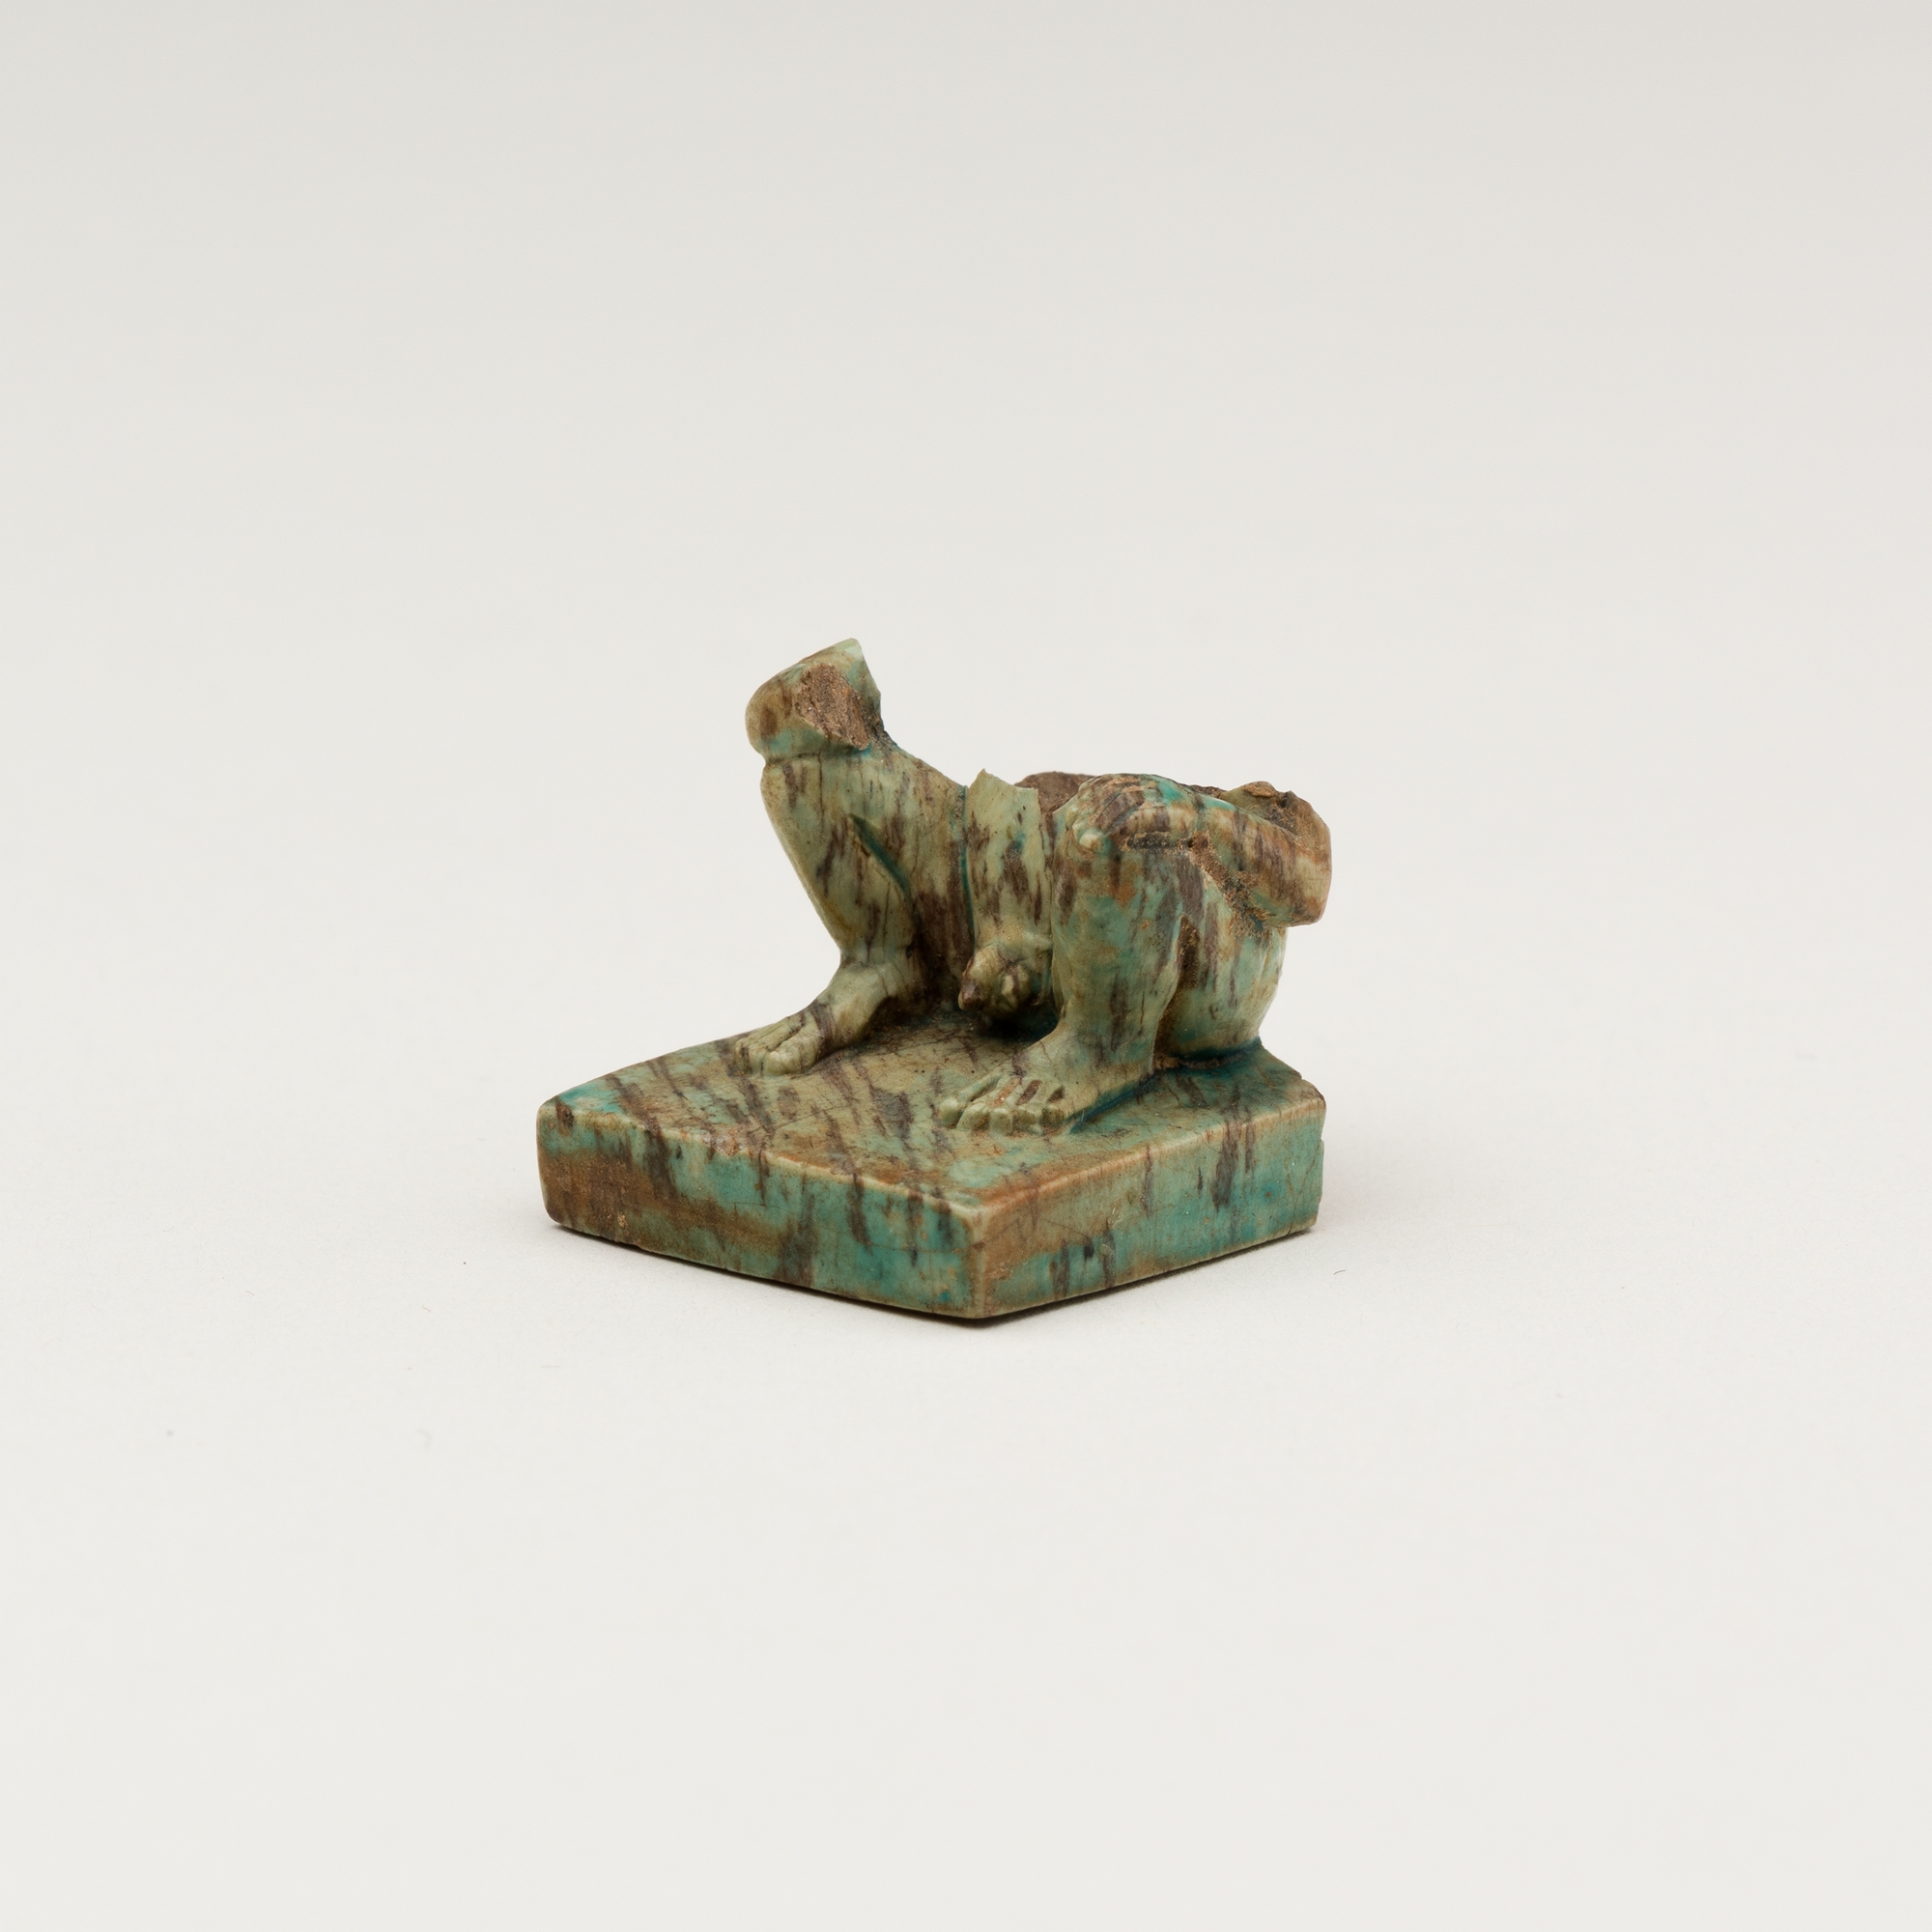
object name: seal, squatting child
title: Stamp Seal in the Form of a Squatting Child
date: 1570-1526 BCE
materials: stone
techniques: glazing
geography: egypt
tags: human figures